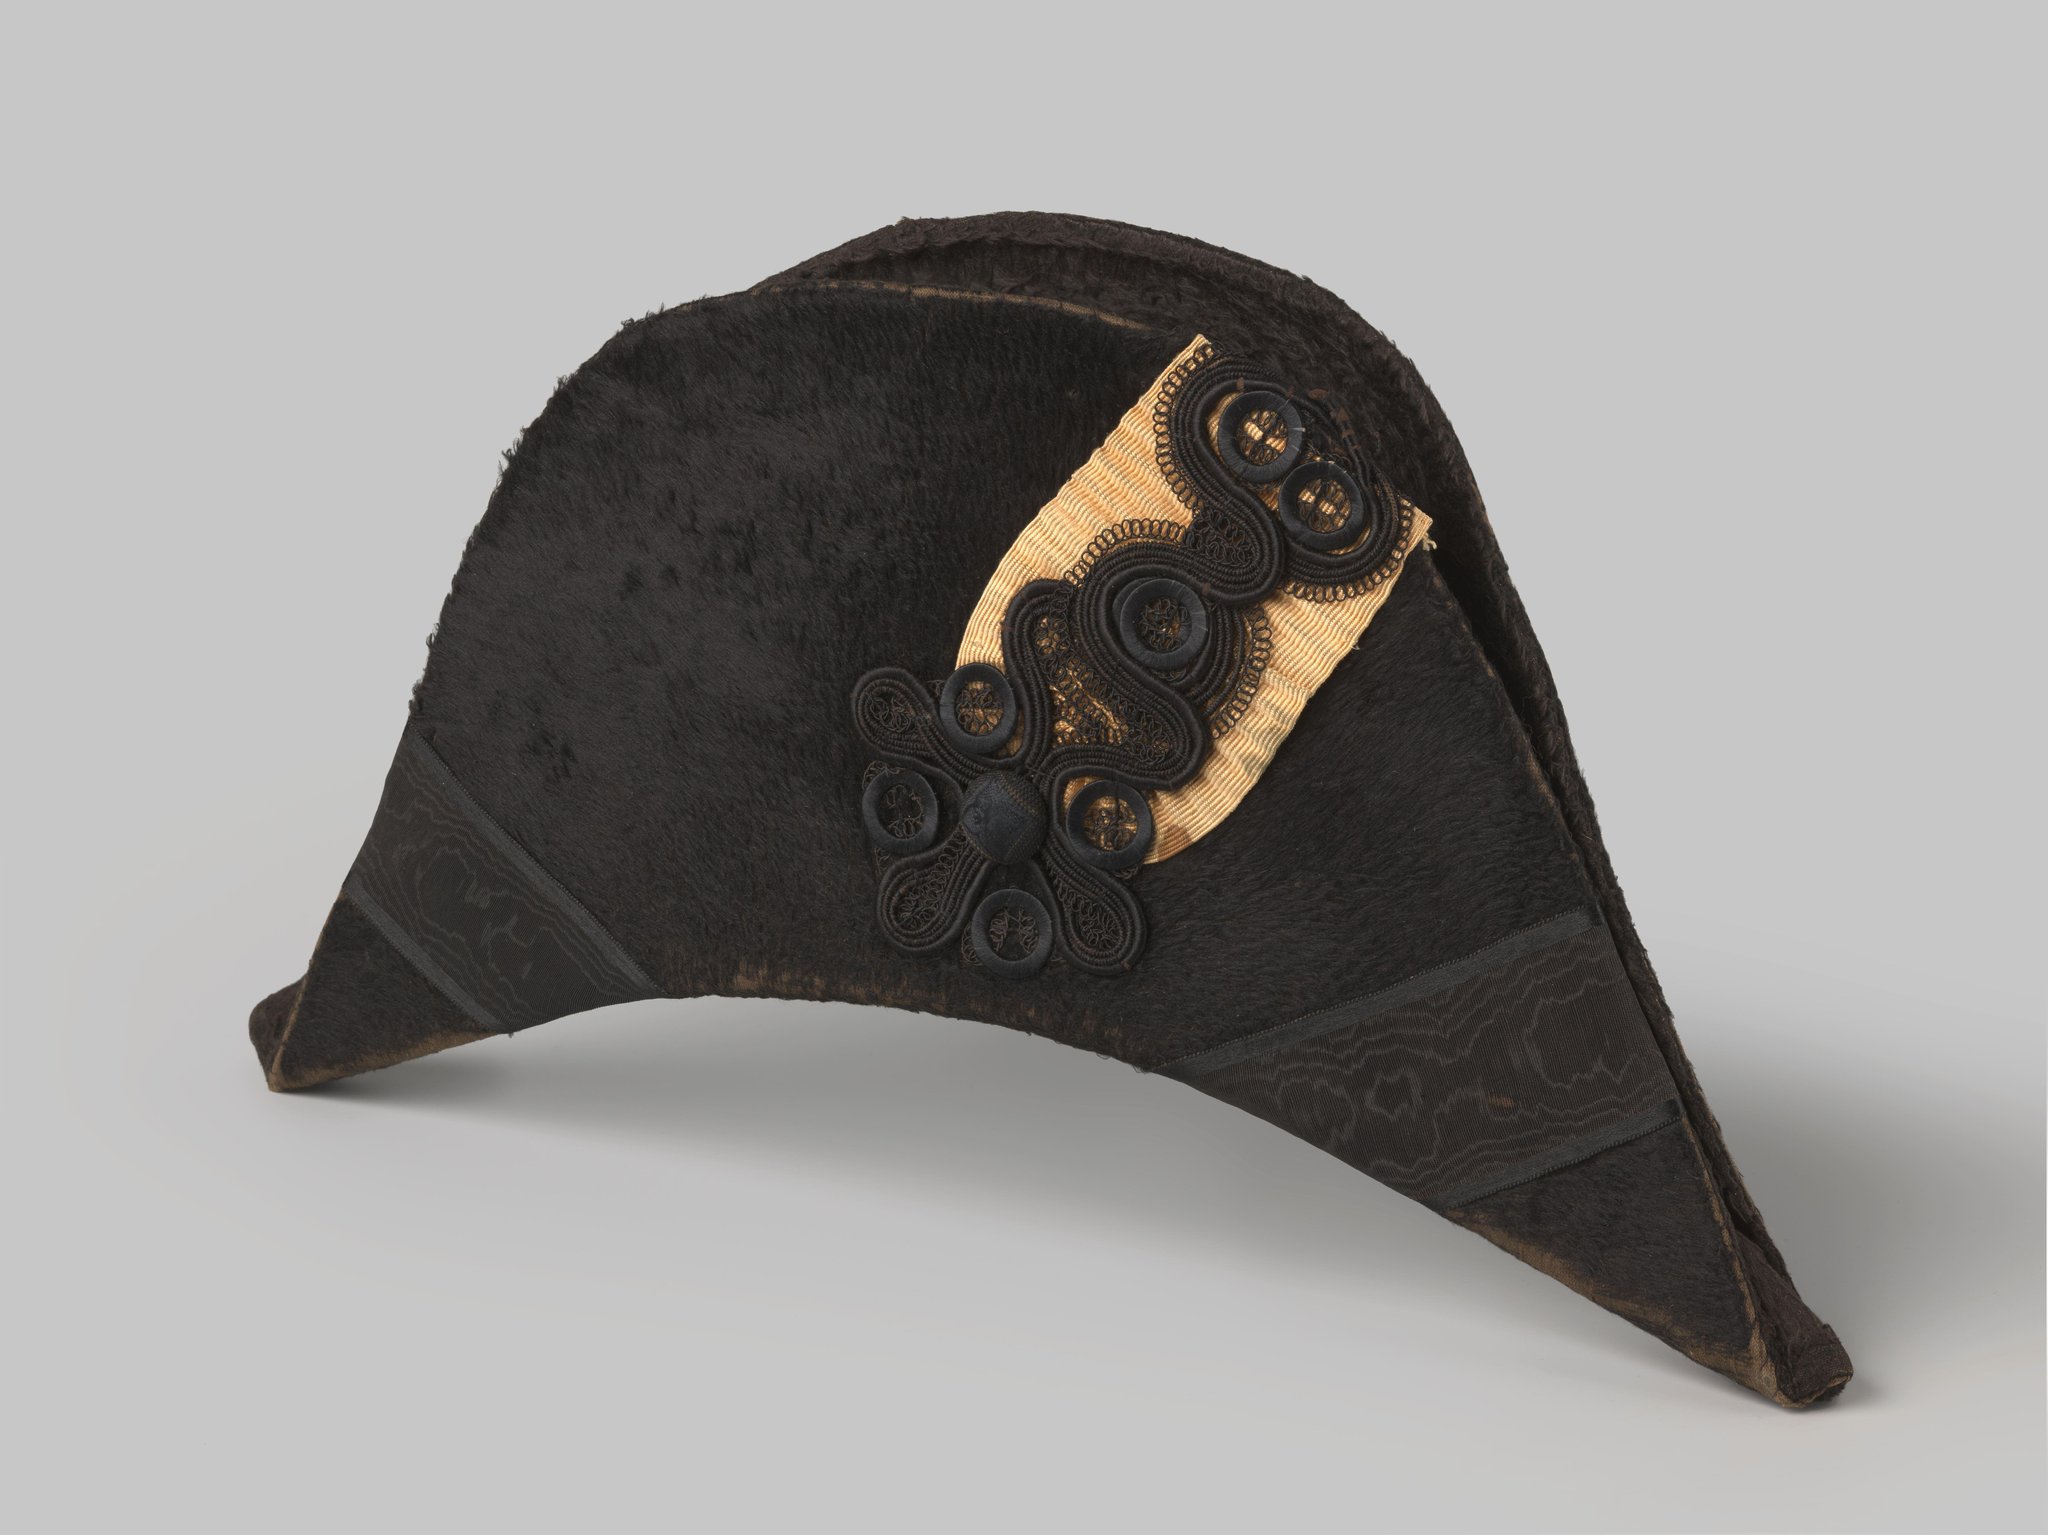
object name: rouwsteek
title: Platte opvouwbare rouwsteek van zwart zijdevelours, versierd met een zwarte bloem over een bleek-oranje geplisseerde kokarde en zwarte moiré linten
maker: Anonymous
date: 1800-1825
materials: silk, velvet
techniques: moire, pleated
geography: netherlands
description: Platte opvouwbare rouwsteek van zwart zijdevelours, versierd met een zwarte bloem over een bleek-oranje geplisseerde kokarde en zwarte moiré linten.